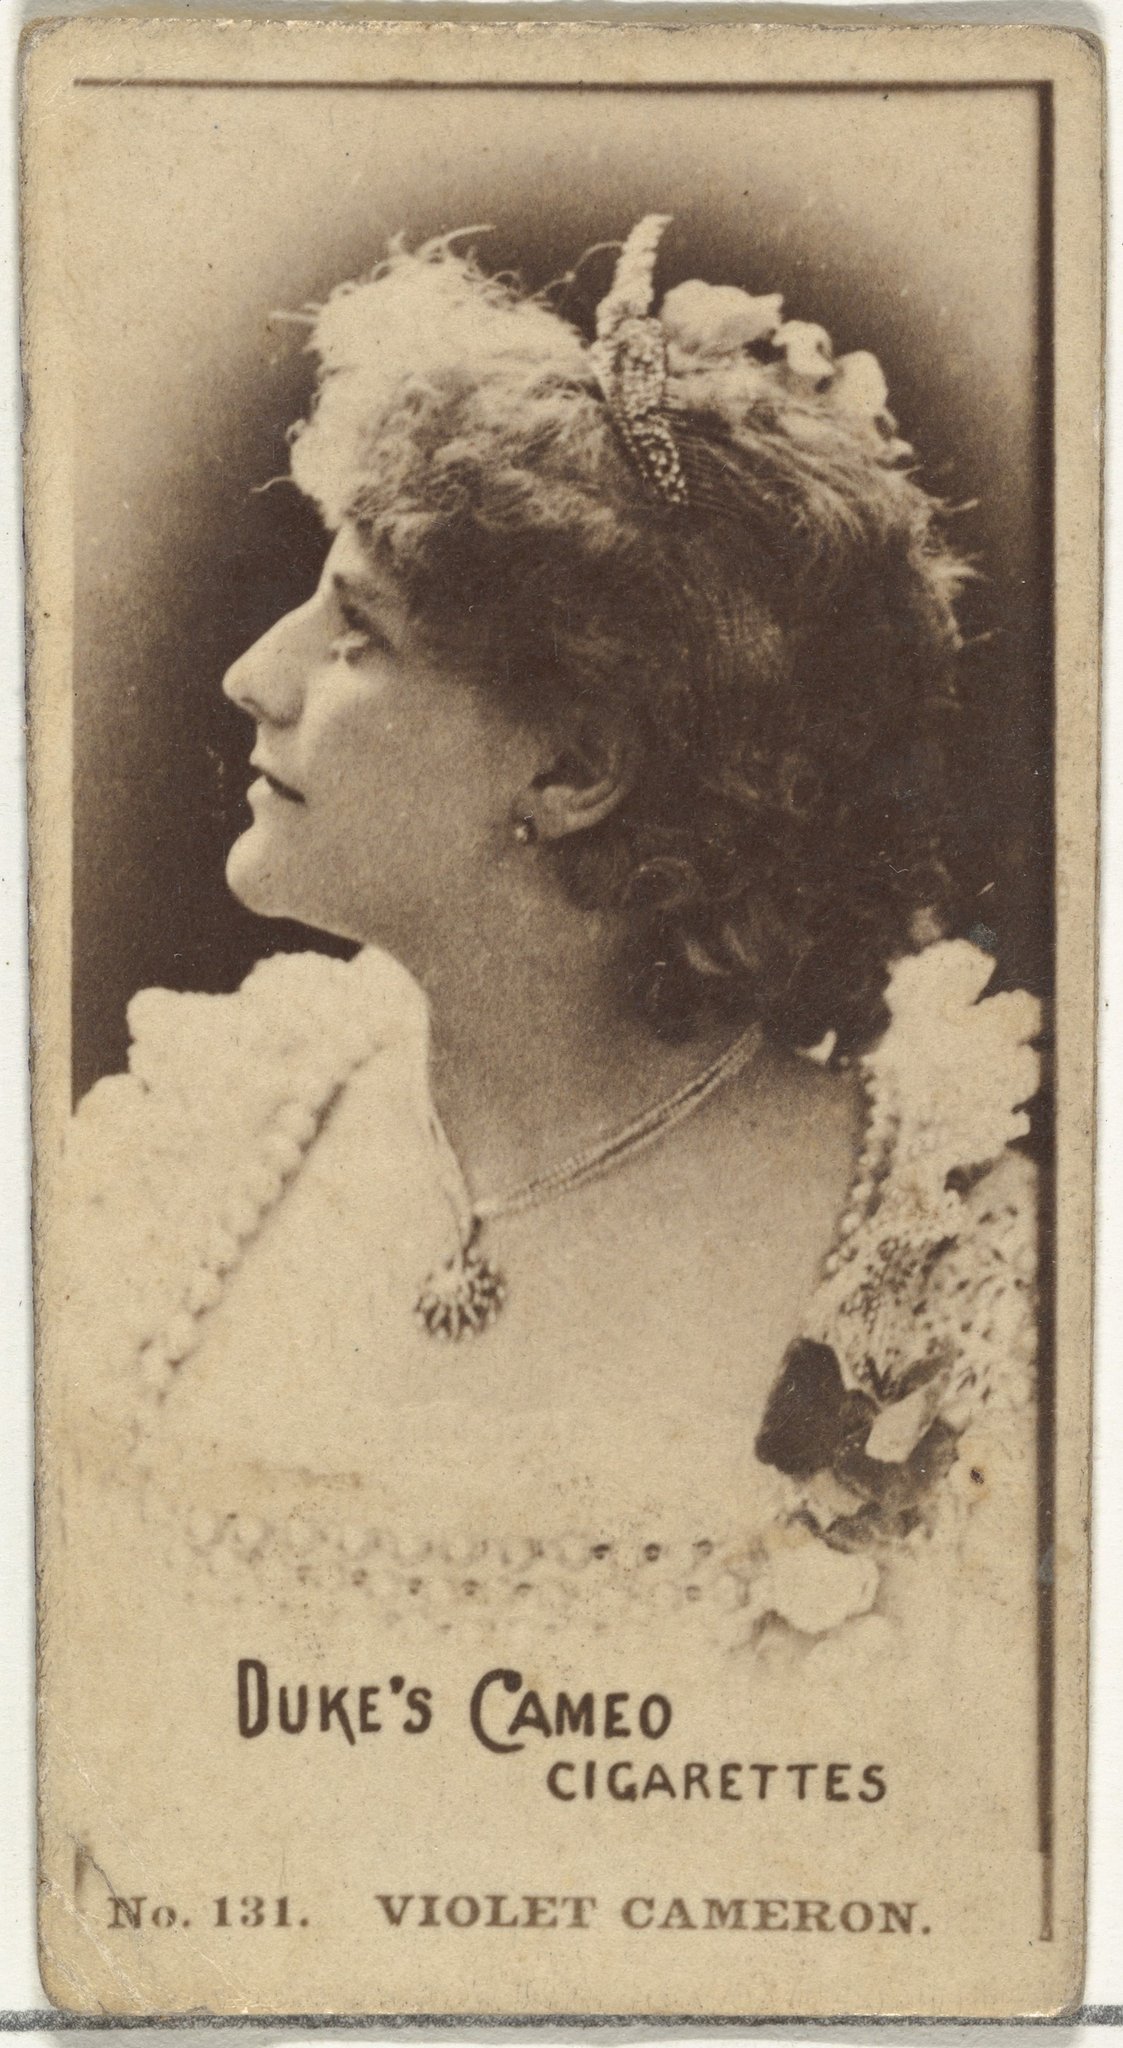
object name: photograph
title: Card Number 131, Violet Cameron, from the Actors and Actresses series (N145-4) issued by Duke Sons & Co. to promote Cameo Cigarettes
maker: w. duke, sons & co.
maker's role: publisher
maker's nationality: american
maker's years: 1870-1920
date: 1880-1889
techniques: albumen silver print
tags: women,actresses